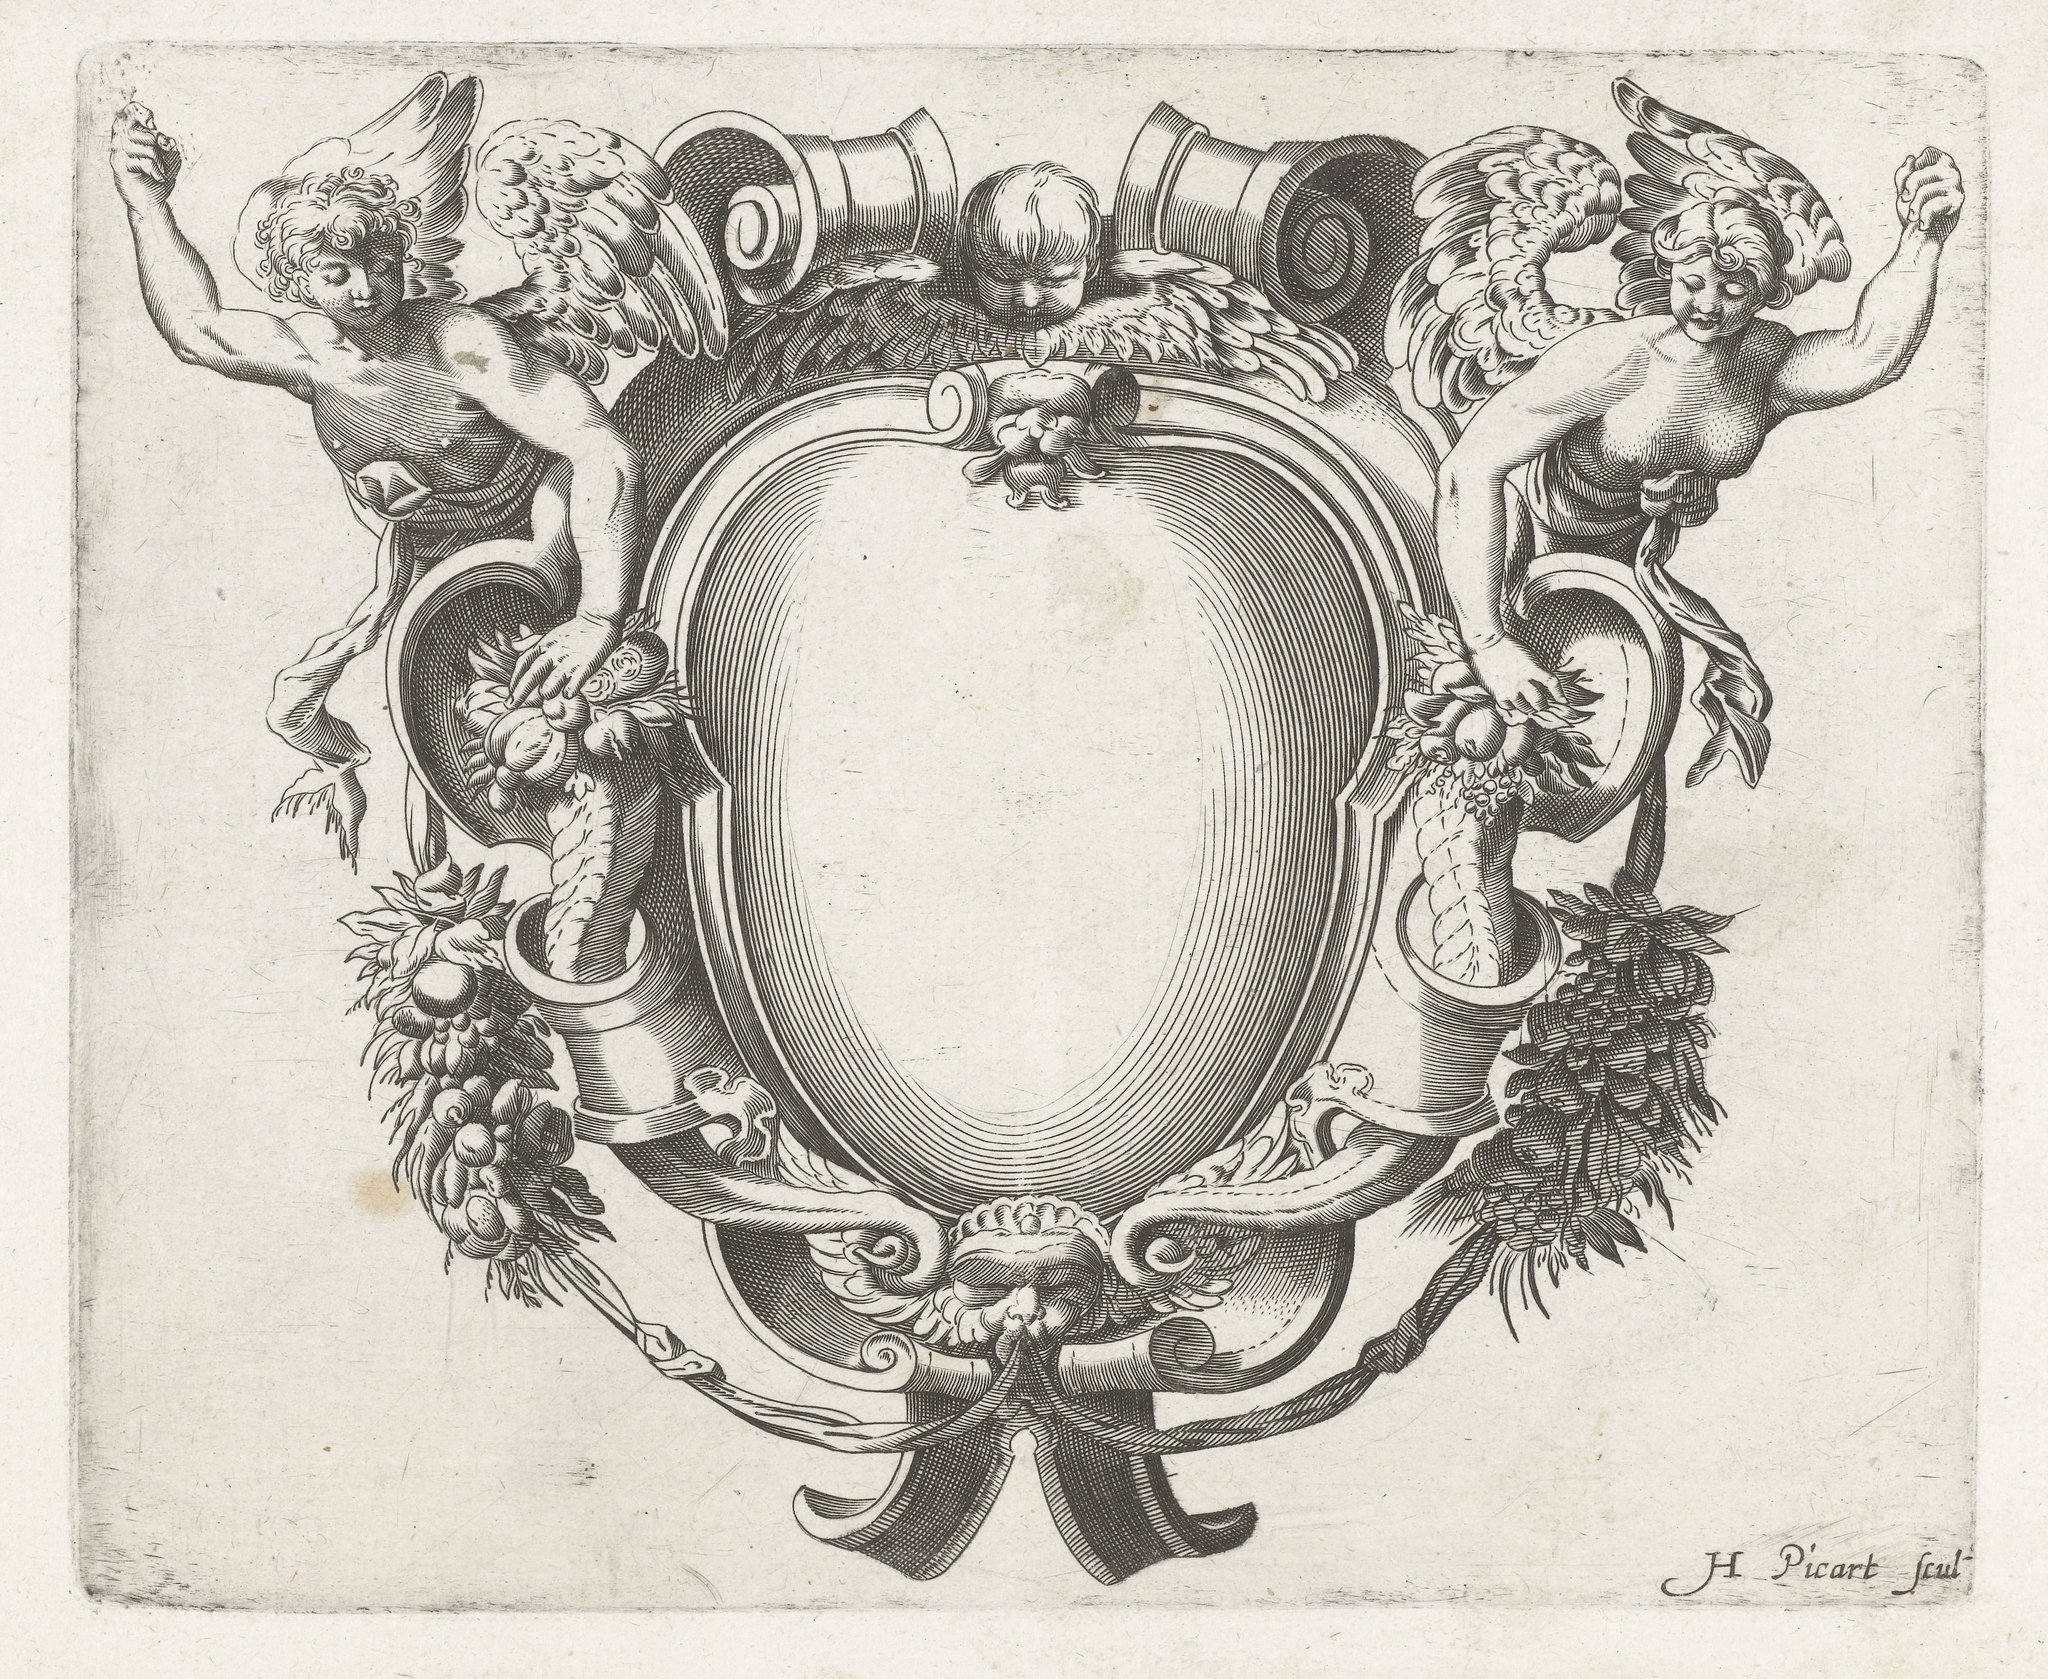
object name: ornament print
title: Cartouches in omlijstingen van rolwerk met grotesken, guirlandes en mascarons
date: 1628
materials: paper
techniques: engraving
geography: france